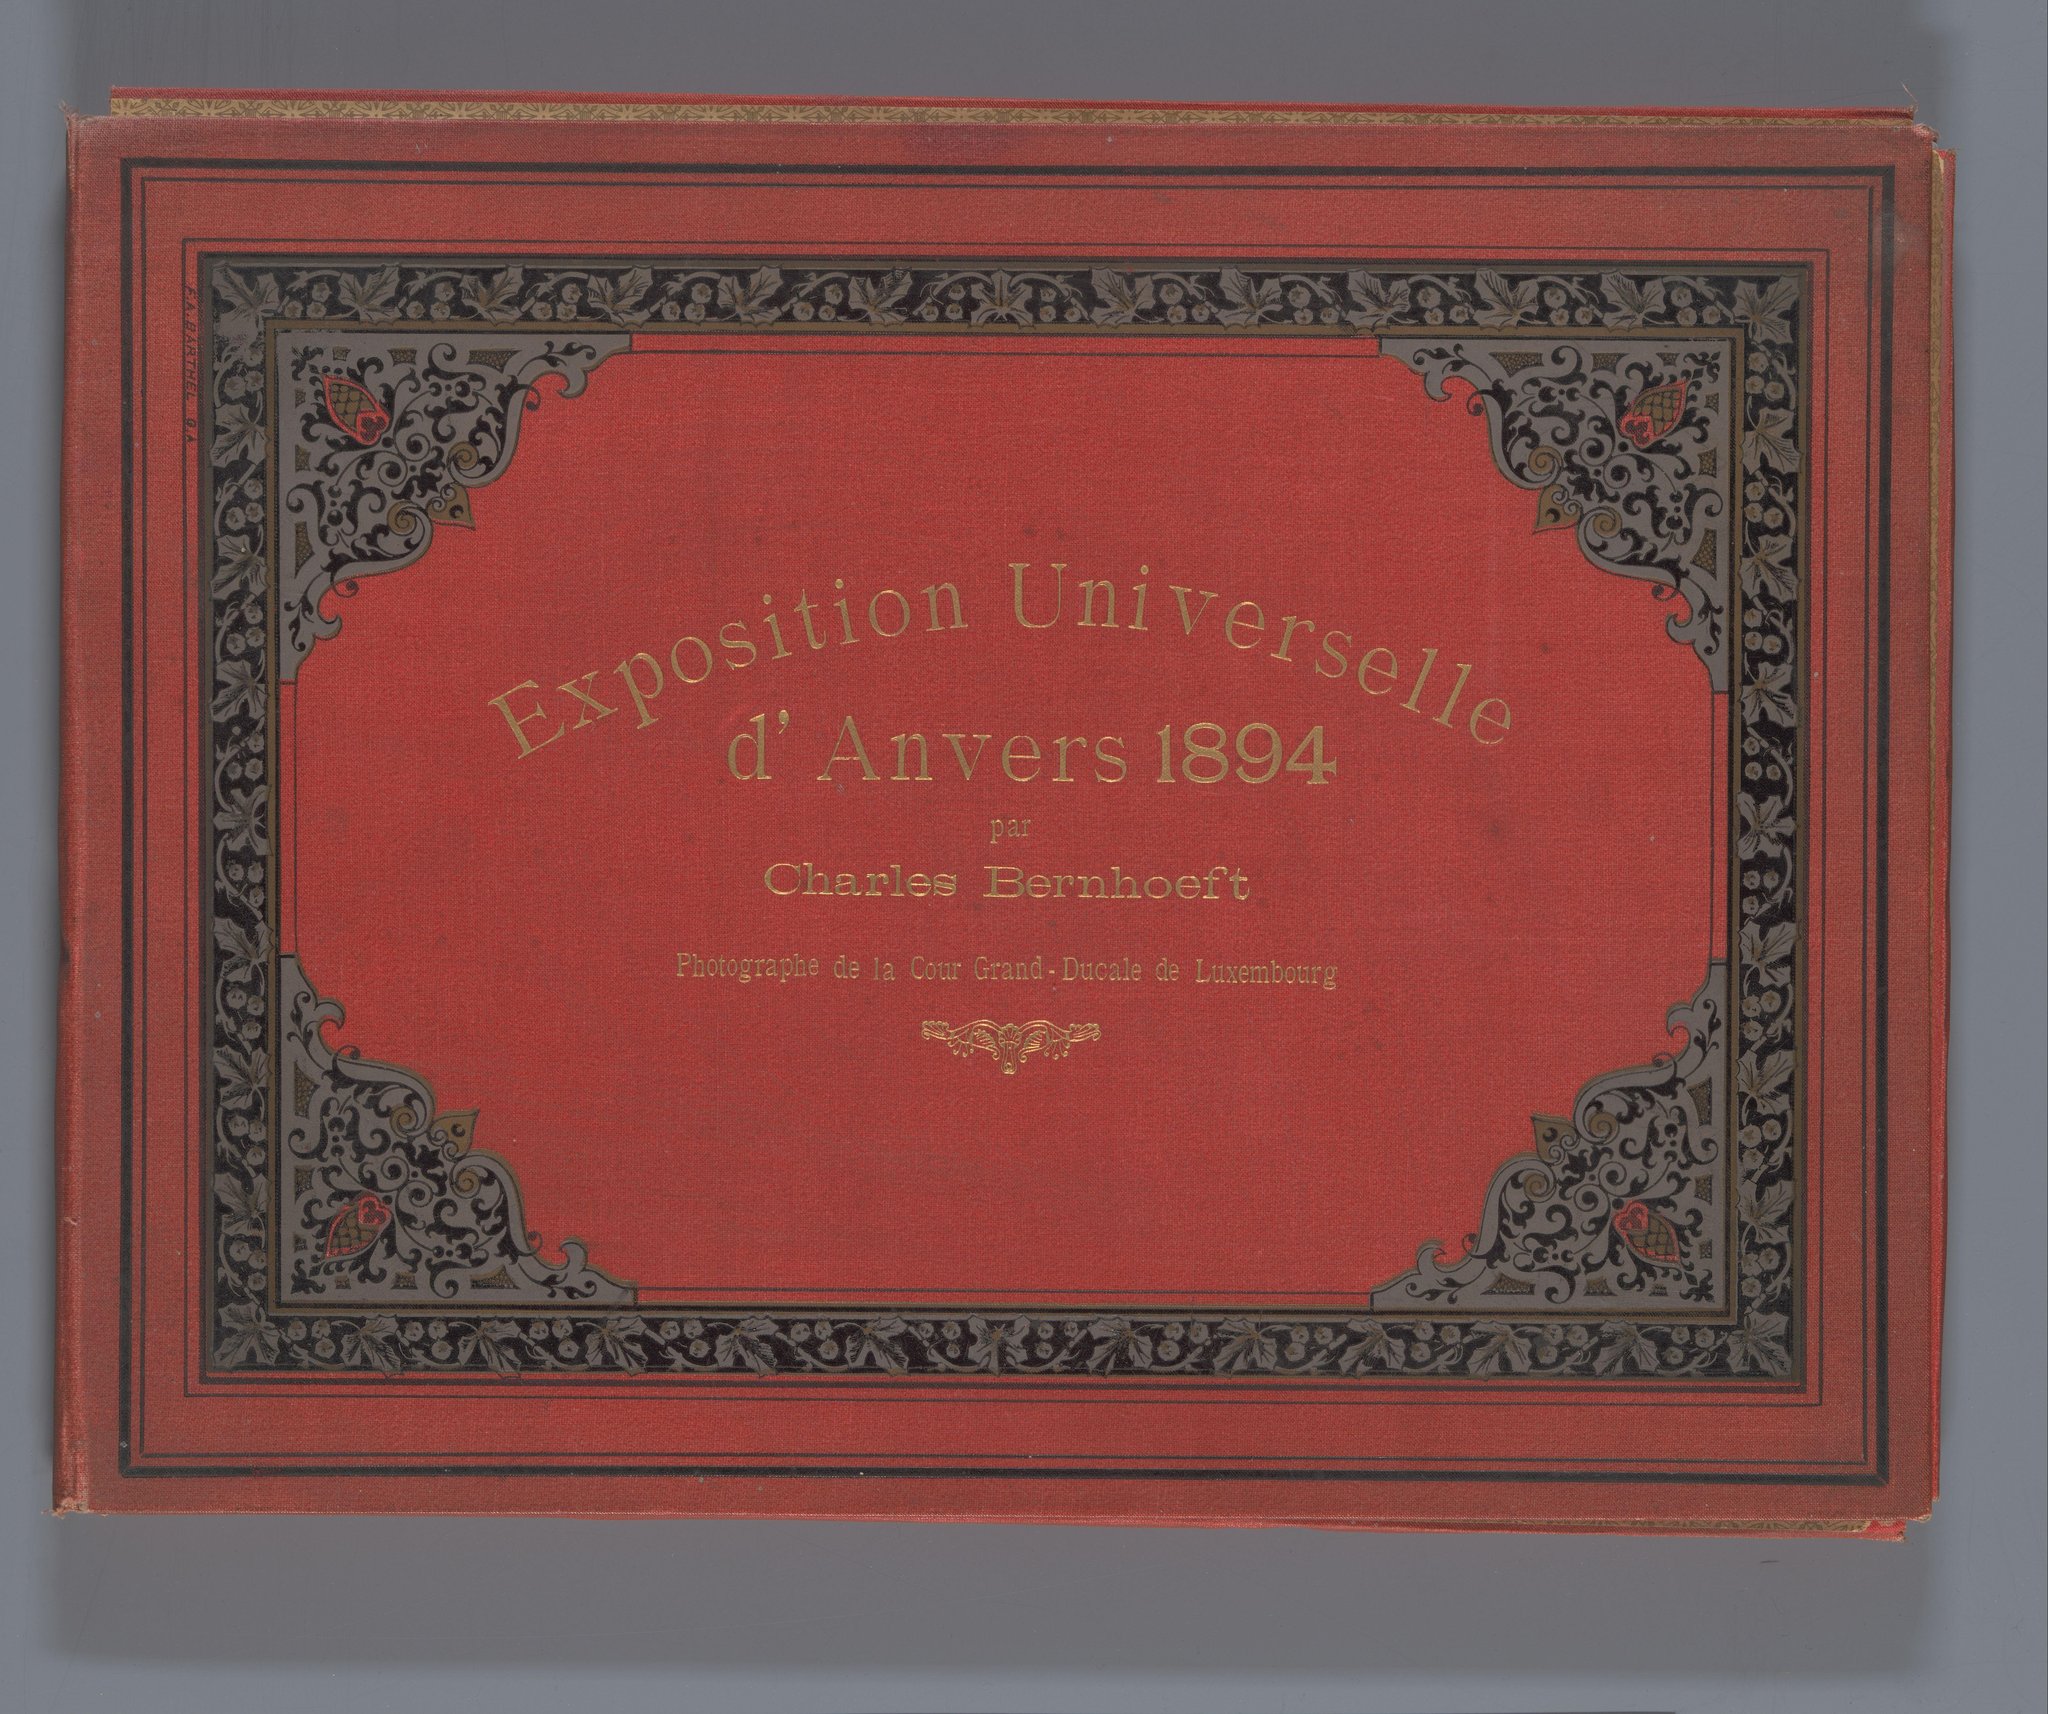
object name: wrapper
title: Exposition universelle d'Anvers 1894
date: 1894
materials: cardboard, paper, textile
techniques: photograph, decorated paper, printing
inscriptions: inscription: ‘FEB/ 1990’